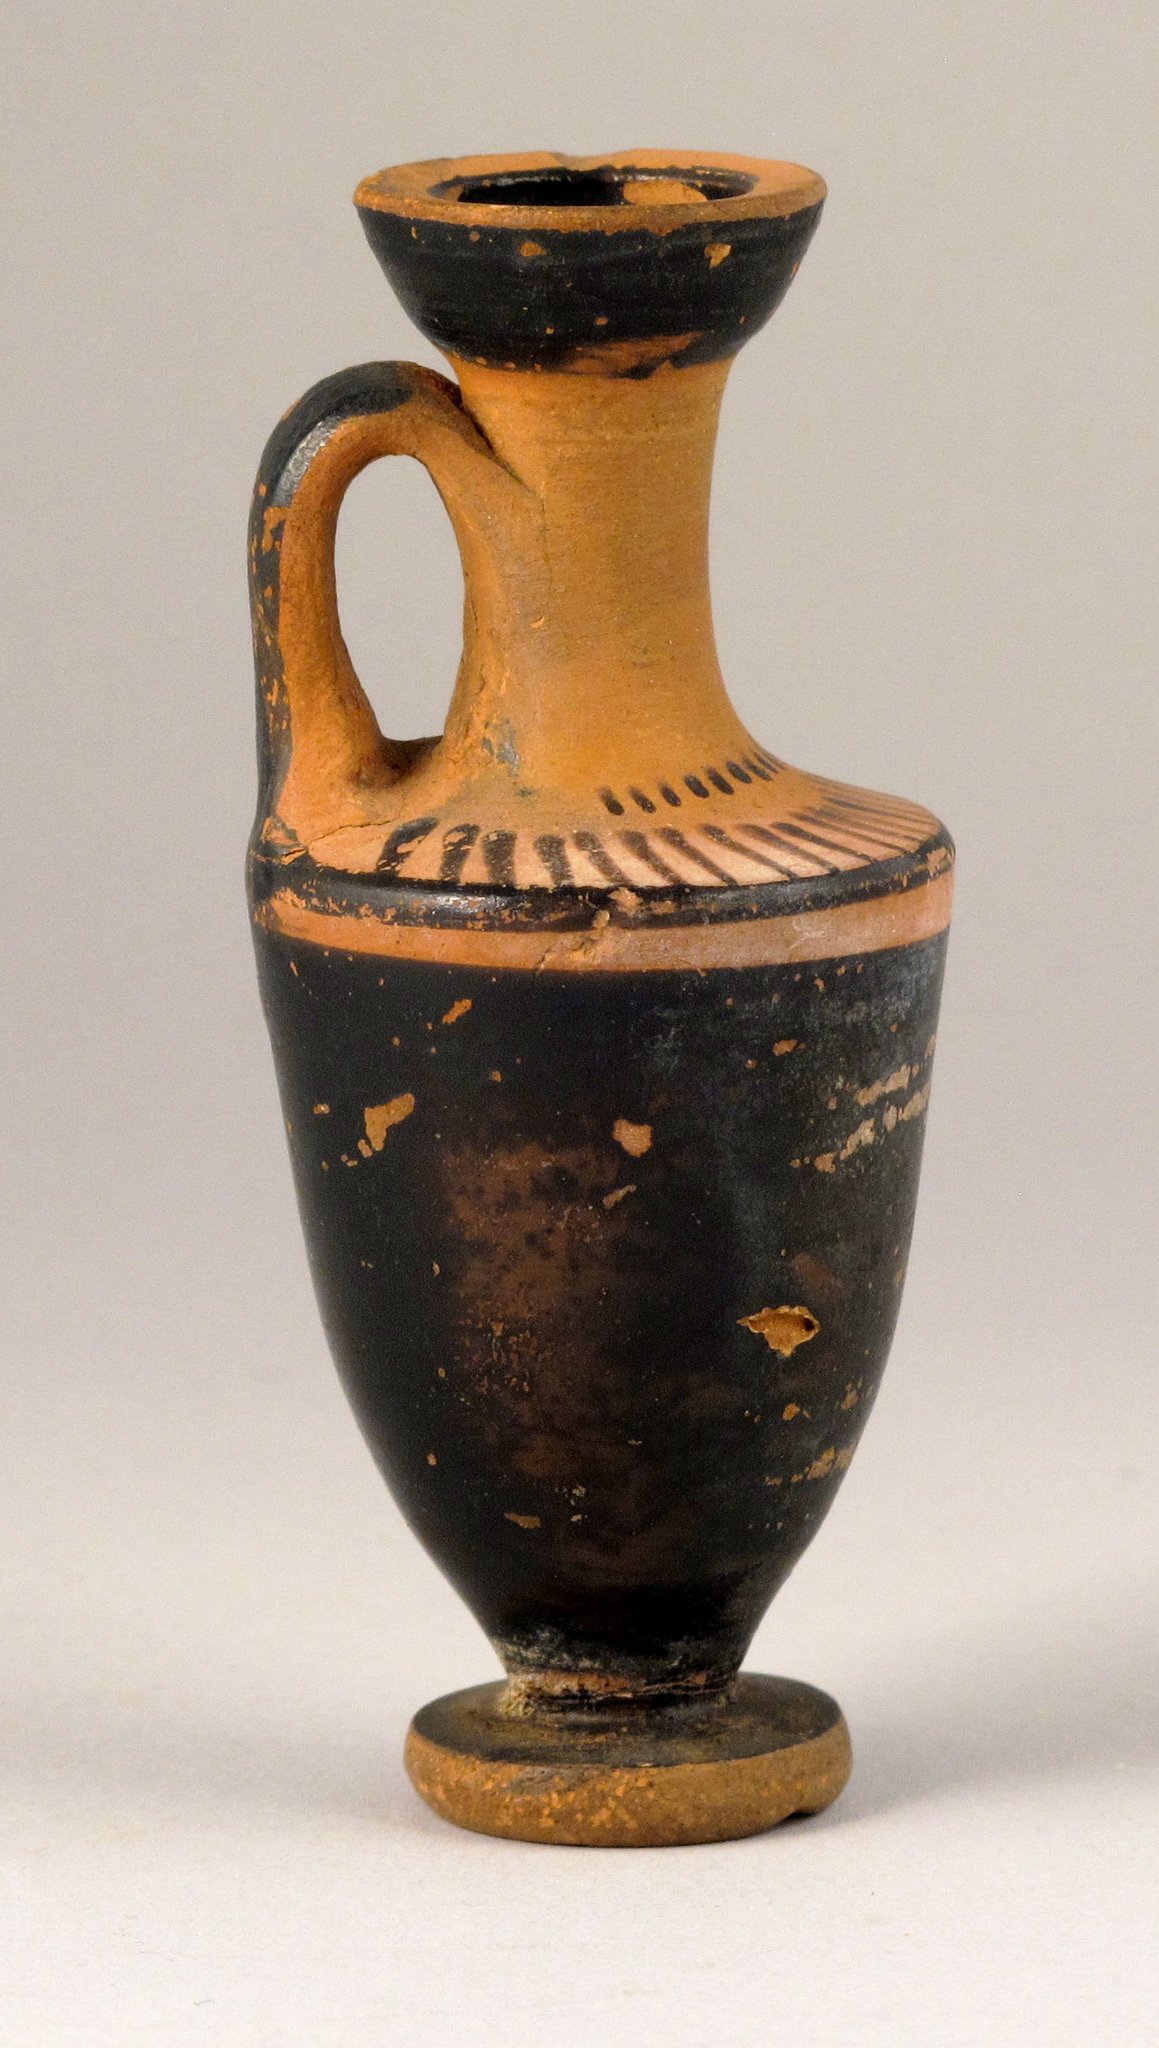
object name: lekythos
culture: greek, attic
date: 500-401 BCE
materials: terracotta